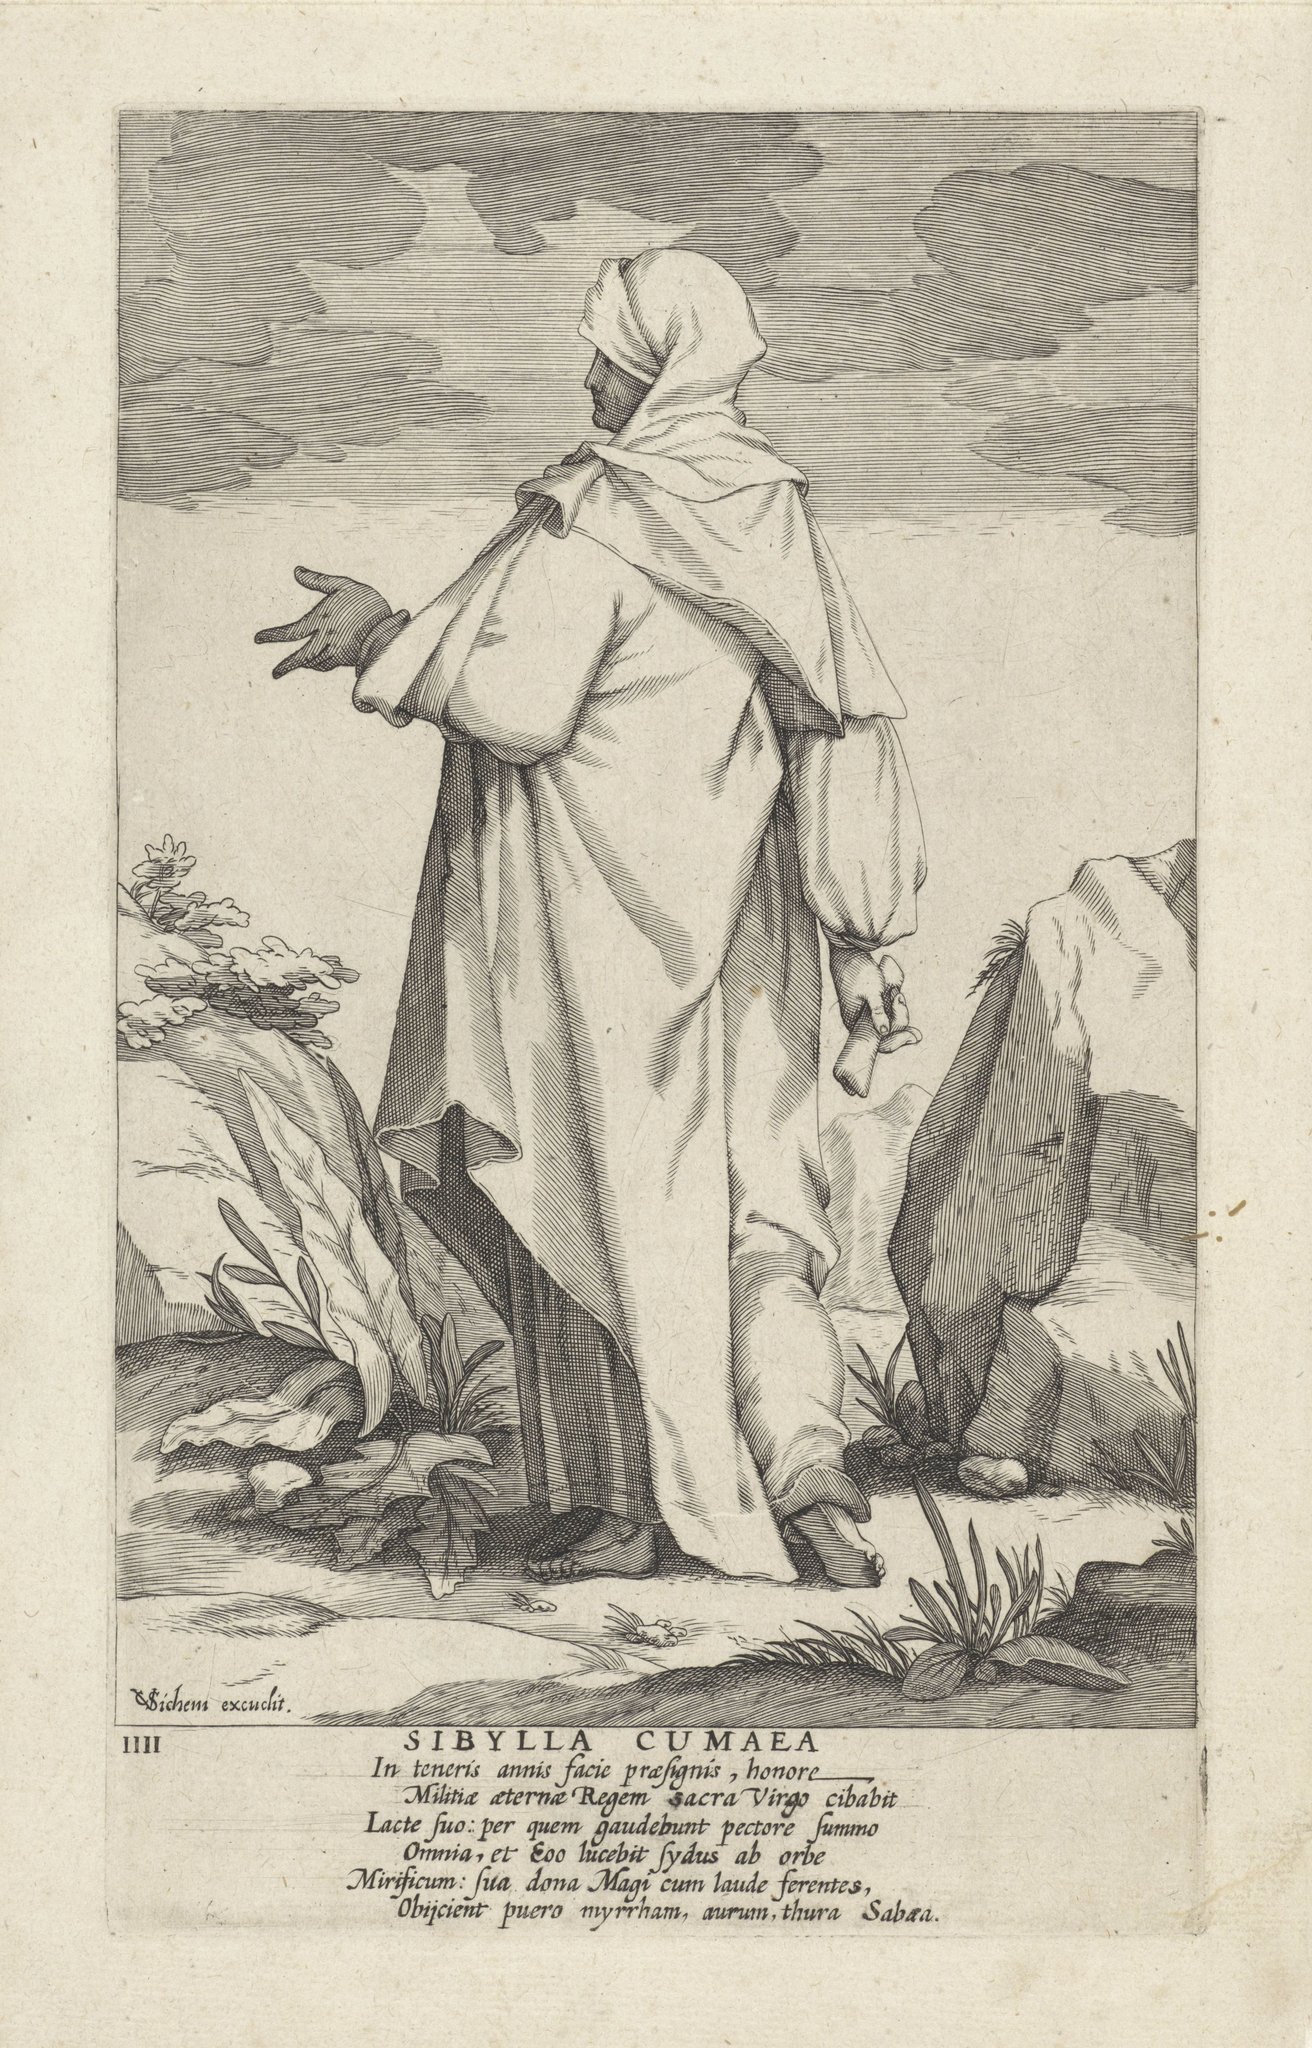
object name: print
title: Twaalf Sibillen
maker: christoffel van sichem (i)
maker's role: print maker, publisher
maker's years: 1546-1624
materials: paper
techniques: engraving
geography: amsterdam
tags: cumaean sibyl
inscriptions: collector's mark: Lugt 2228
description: Prent tevens gebruikt in: (Onuphrius Panvinius). Beschryvinghe ende heerelĳcke afbeeldinghe der twaelf Sibyllen. Vertaald uit het Latijn door R. Lubbaeus. Amsterdam: C. van Sichem, 1608.